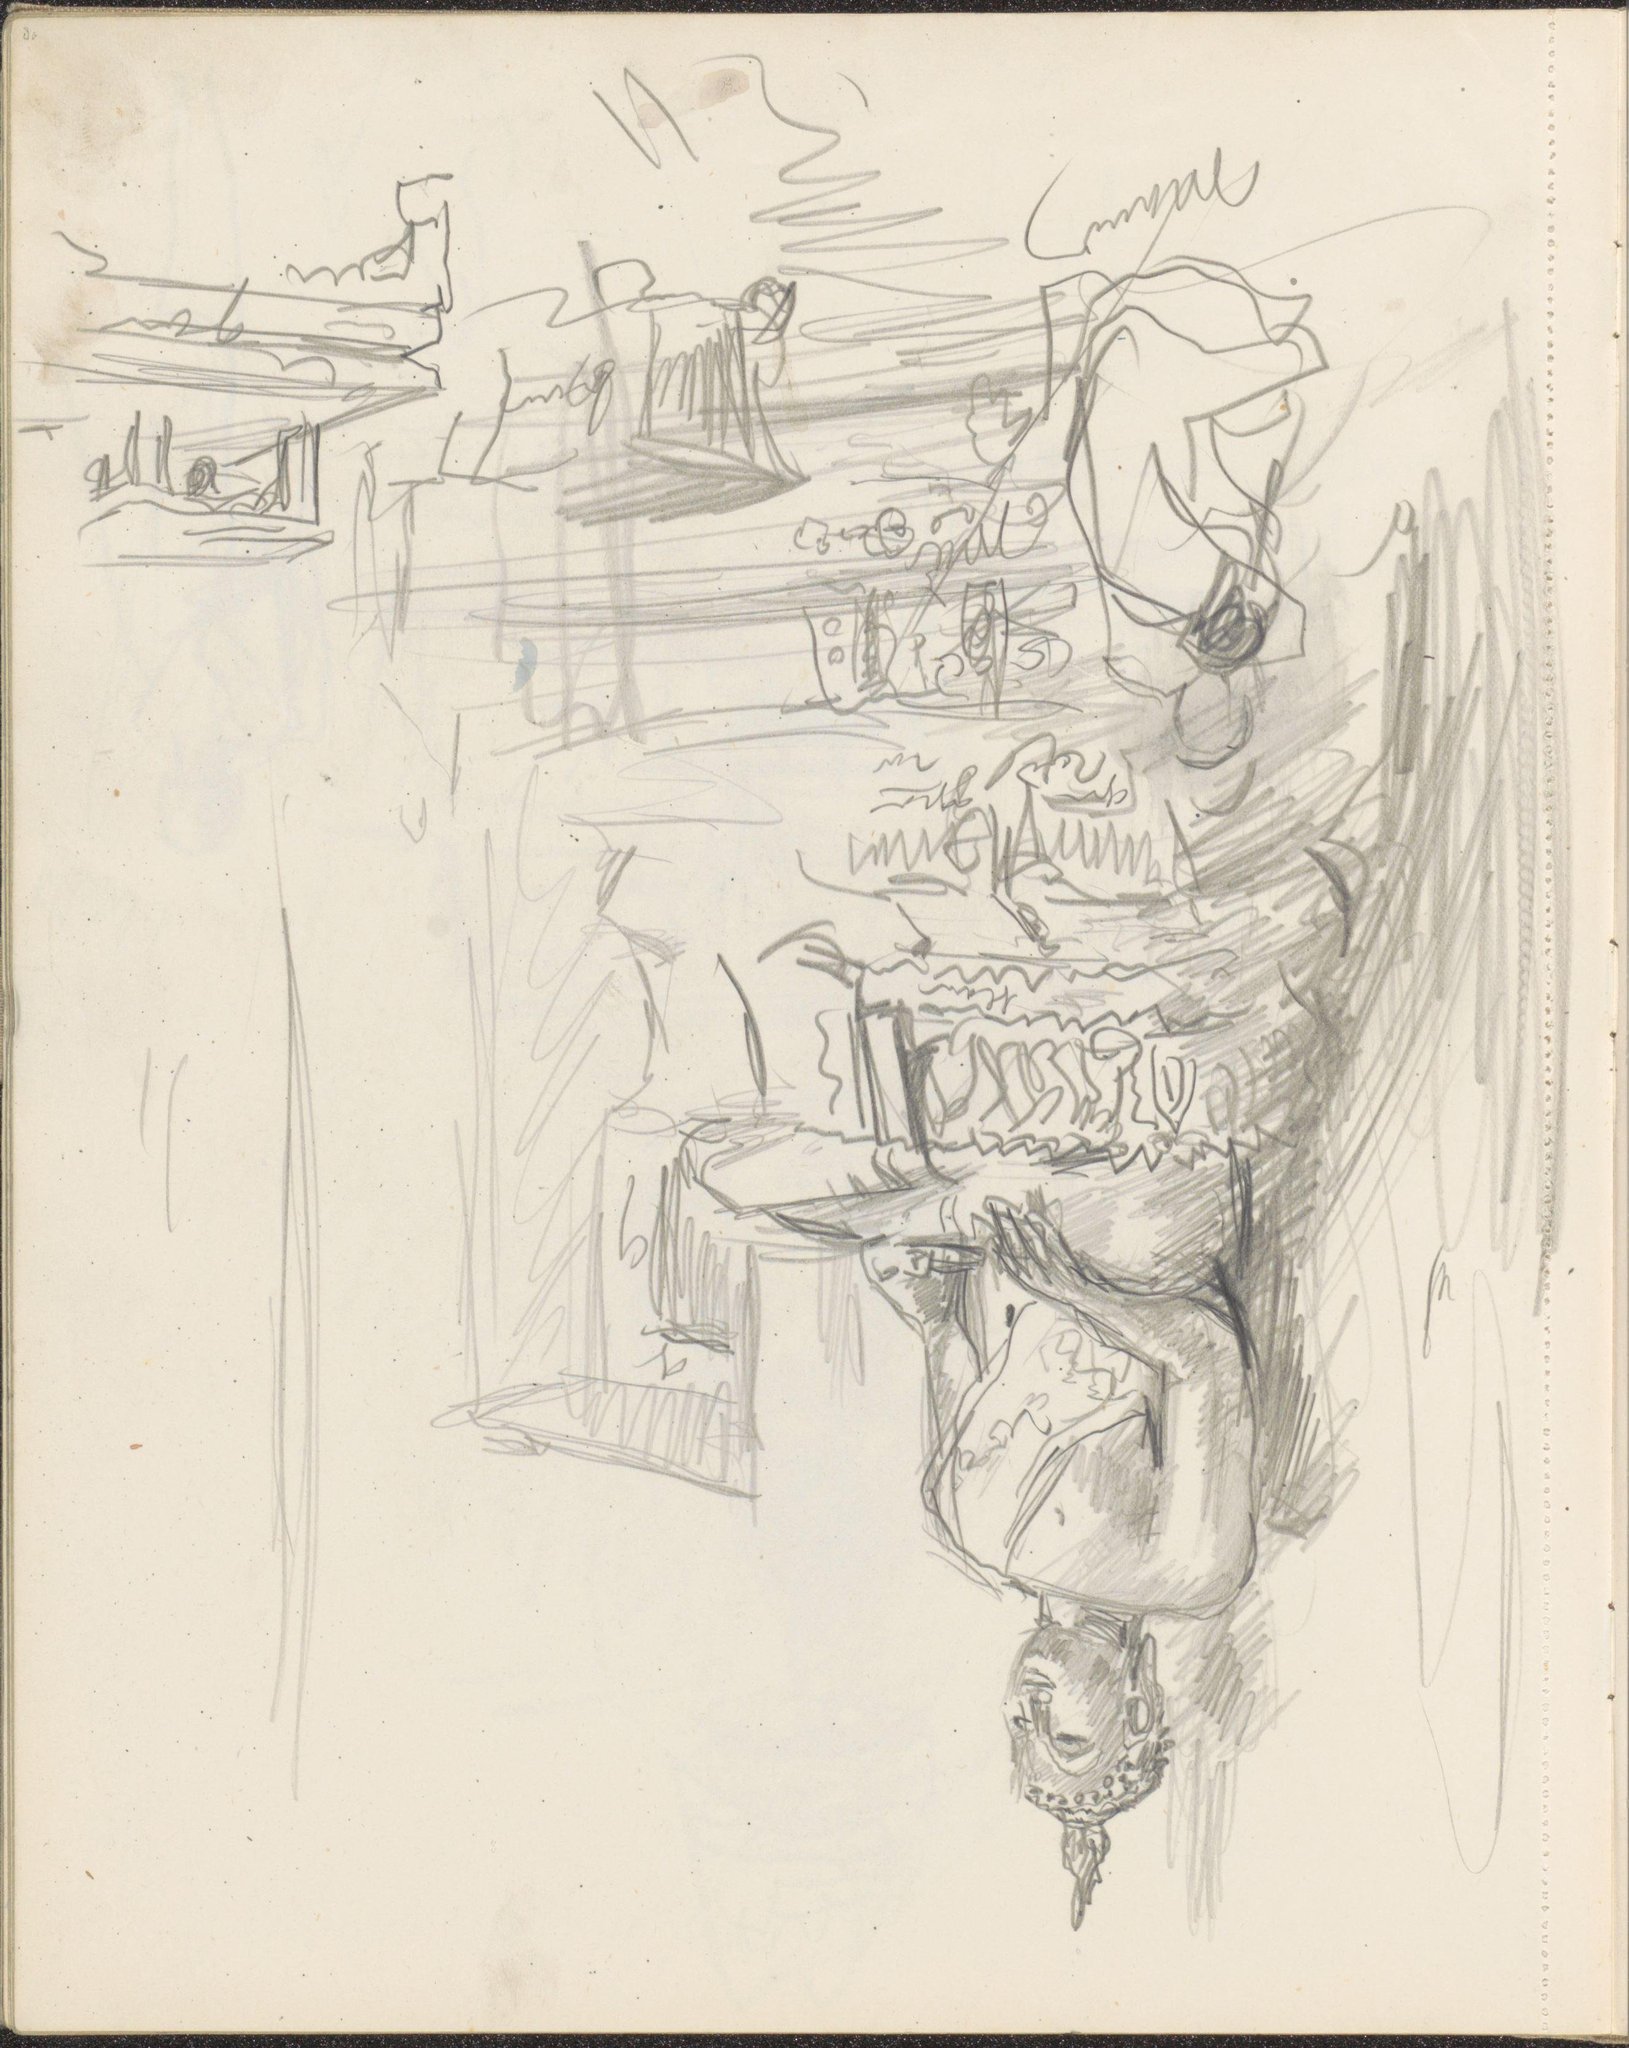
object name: sketchbook leaf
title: Knielende figuur bij een altaar met een Boeddhabeeld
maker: marius bauer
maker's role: draughtsman, print maker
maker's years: 1867-1932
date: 1931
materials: paper, pencil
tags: altar ~ hinduism, buddhism, jainism, kneeling figure, statues, paintings, etc. ~ objects of worship (hinduism, buddhism, jainism)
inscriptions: kleurnotitie, handgeschreven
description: Pagina 80 uit een schetsboek met 48 bladen.